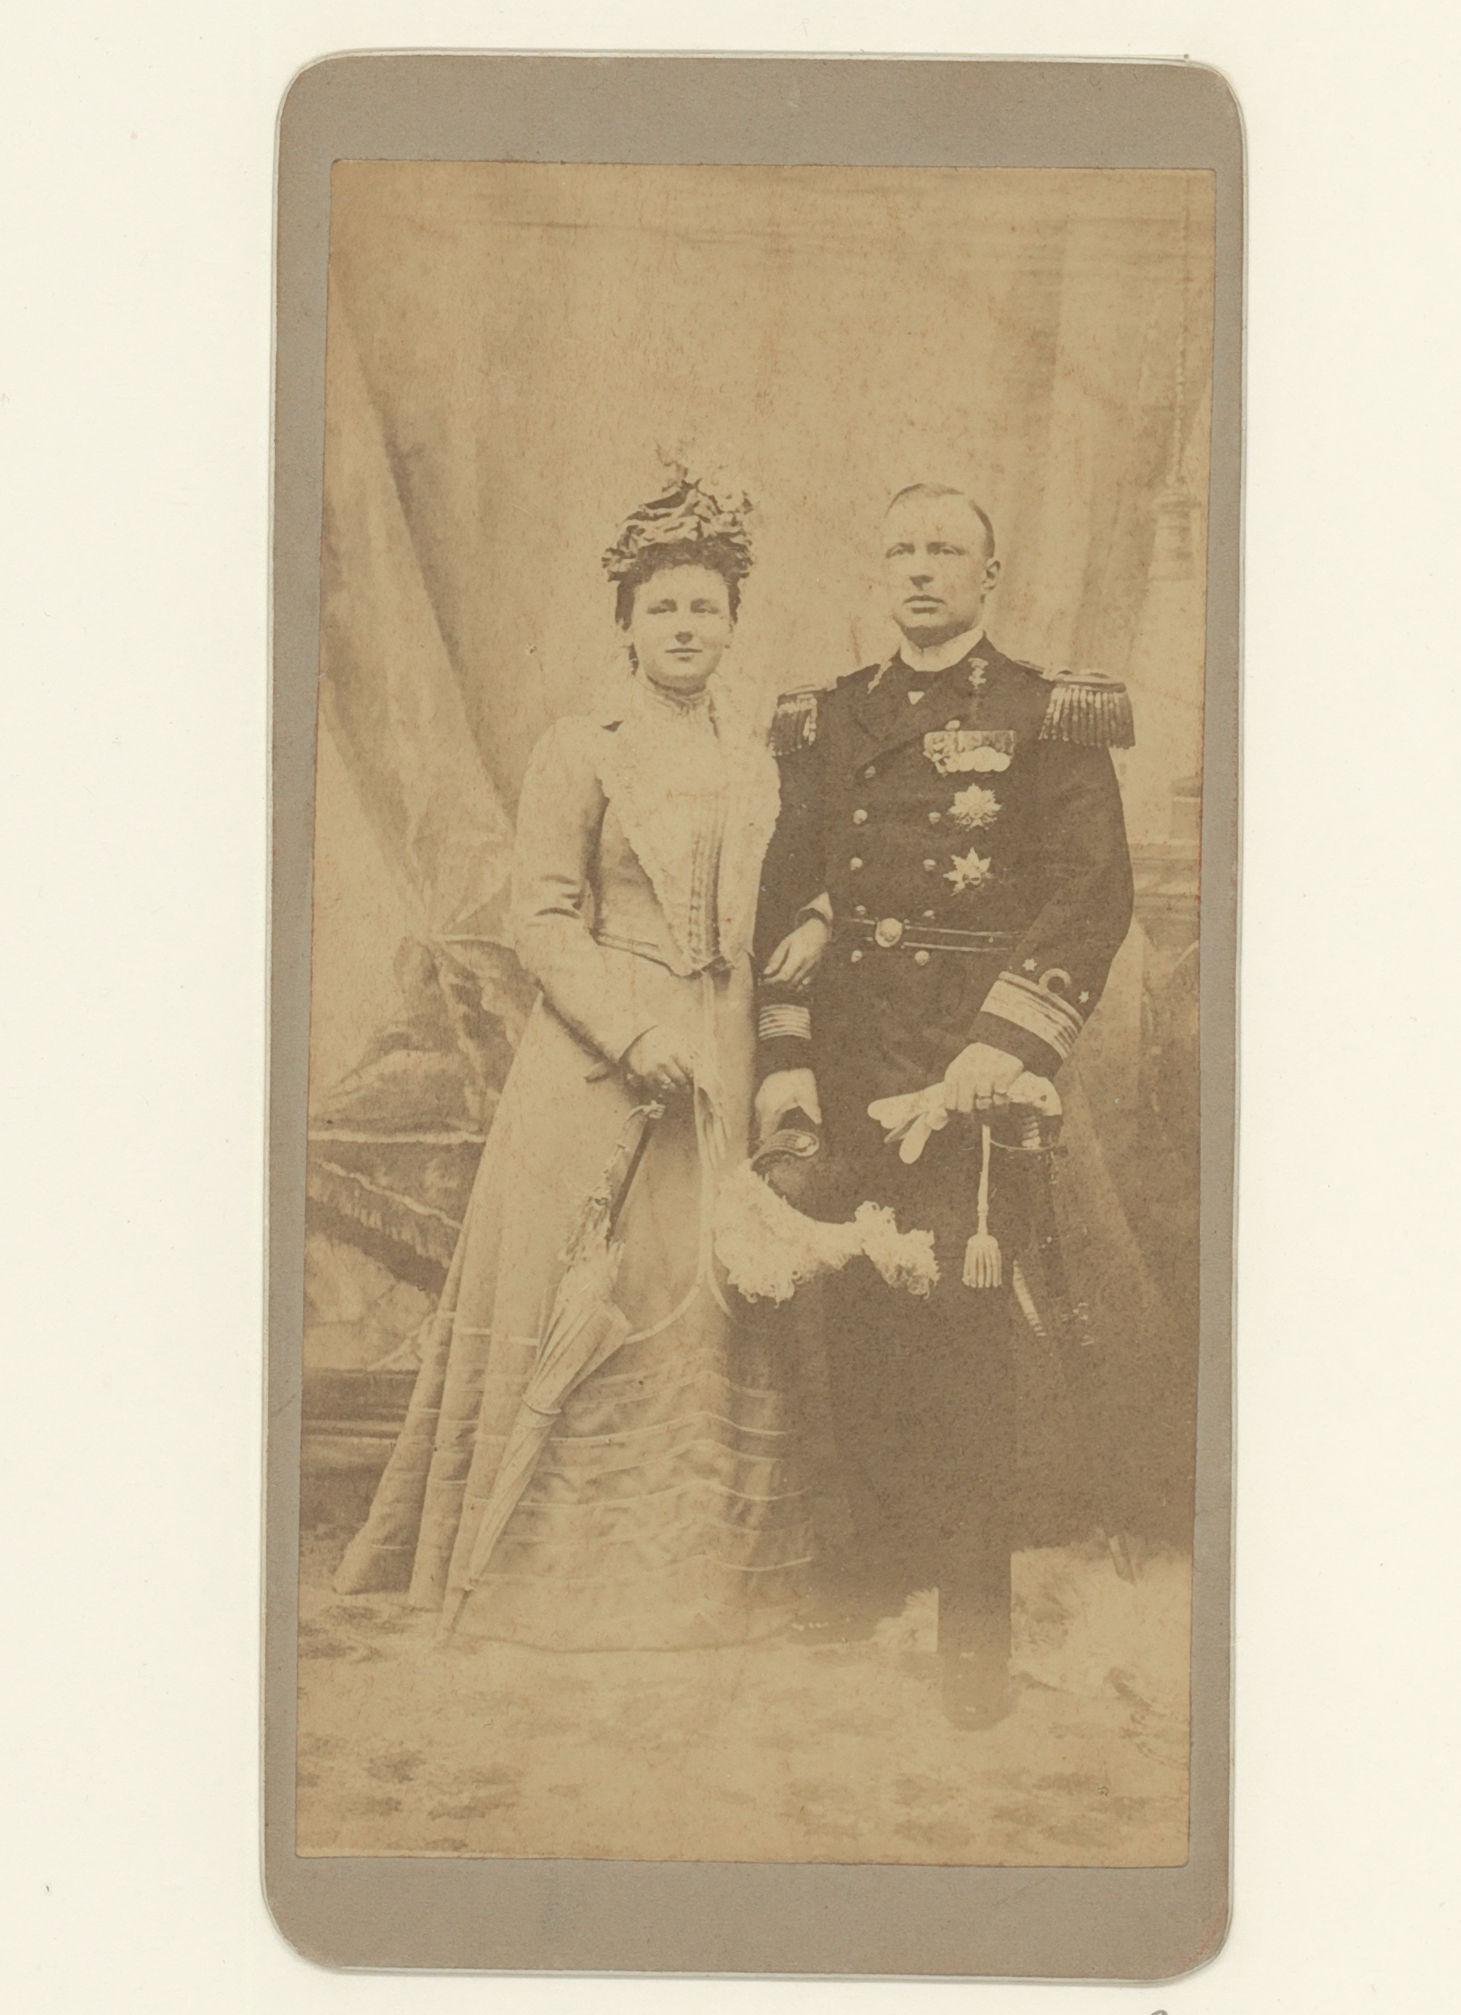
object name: photograph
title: Portret van Wilhelmina, koningin der Nederlanden, en Hendrik van Mecklenburg-Schwerin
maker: Anonymous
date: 1901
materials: cardboard, paper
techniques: albumen print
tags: print maker, wilhelmina of the netherlands, the hague, hendrik (prins der nederlanden (1876-1934)), historical persons - bb - woman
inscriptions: collector's mark: Lugt 1641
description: Onderwerpsrubrieken binnen de Atlas Zeden en Gewoonten: Portretten, Portretten van Vorsten uit het huis van Oranje, Regeerende Vorsten, Koningen uit het huis van Oranje.